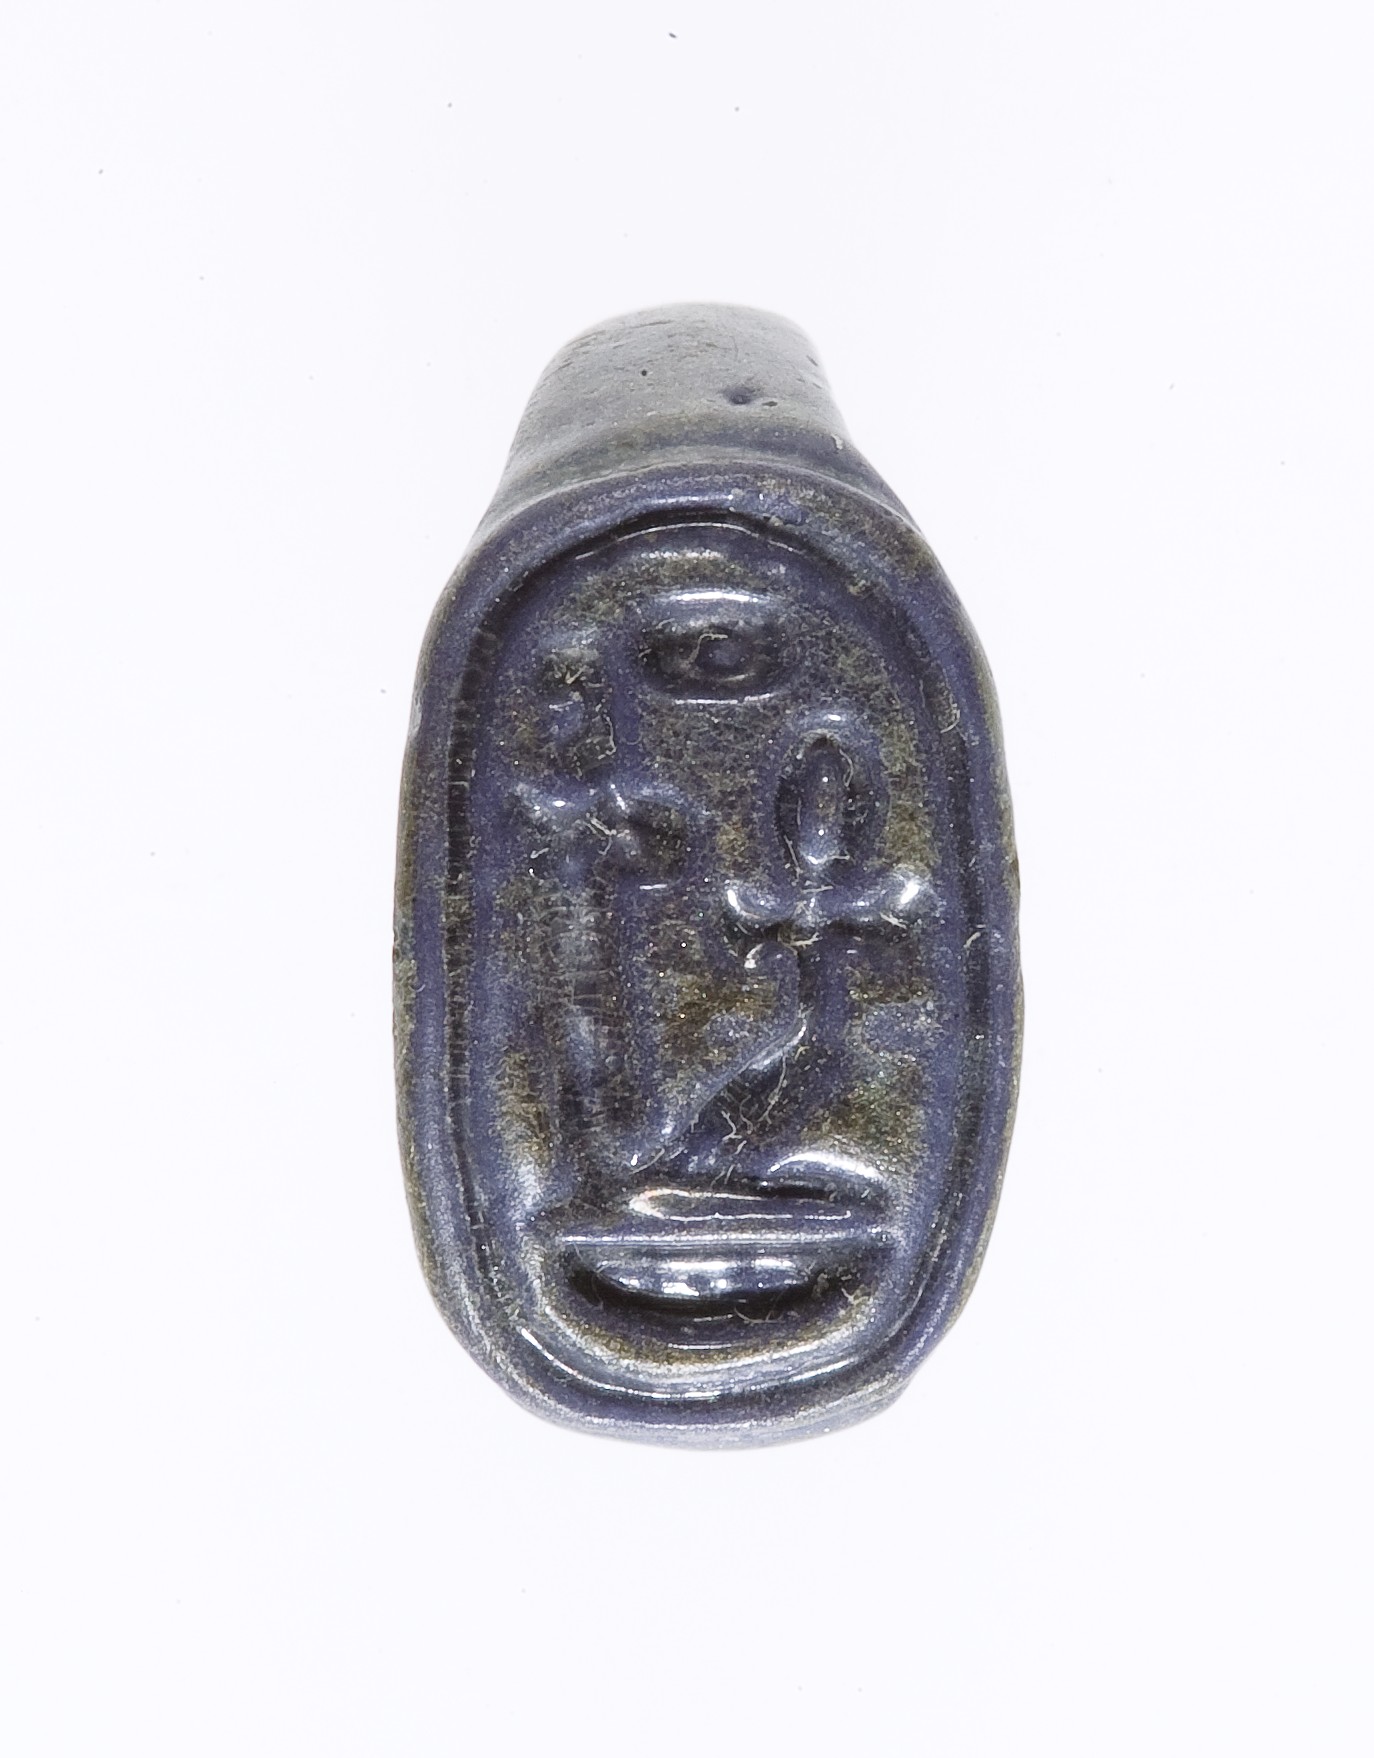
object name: ring, amenhotep iii, nebmaatre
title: Ring Inscribed with the Throne Name of Amenhotep III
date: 1390-1352 BCE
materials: faience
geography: egypt